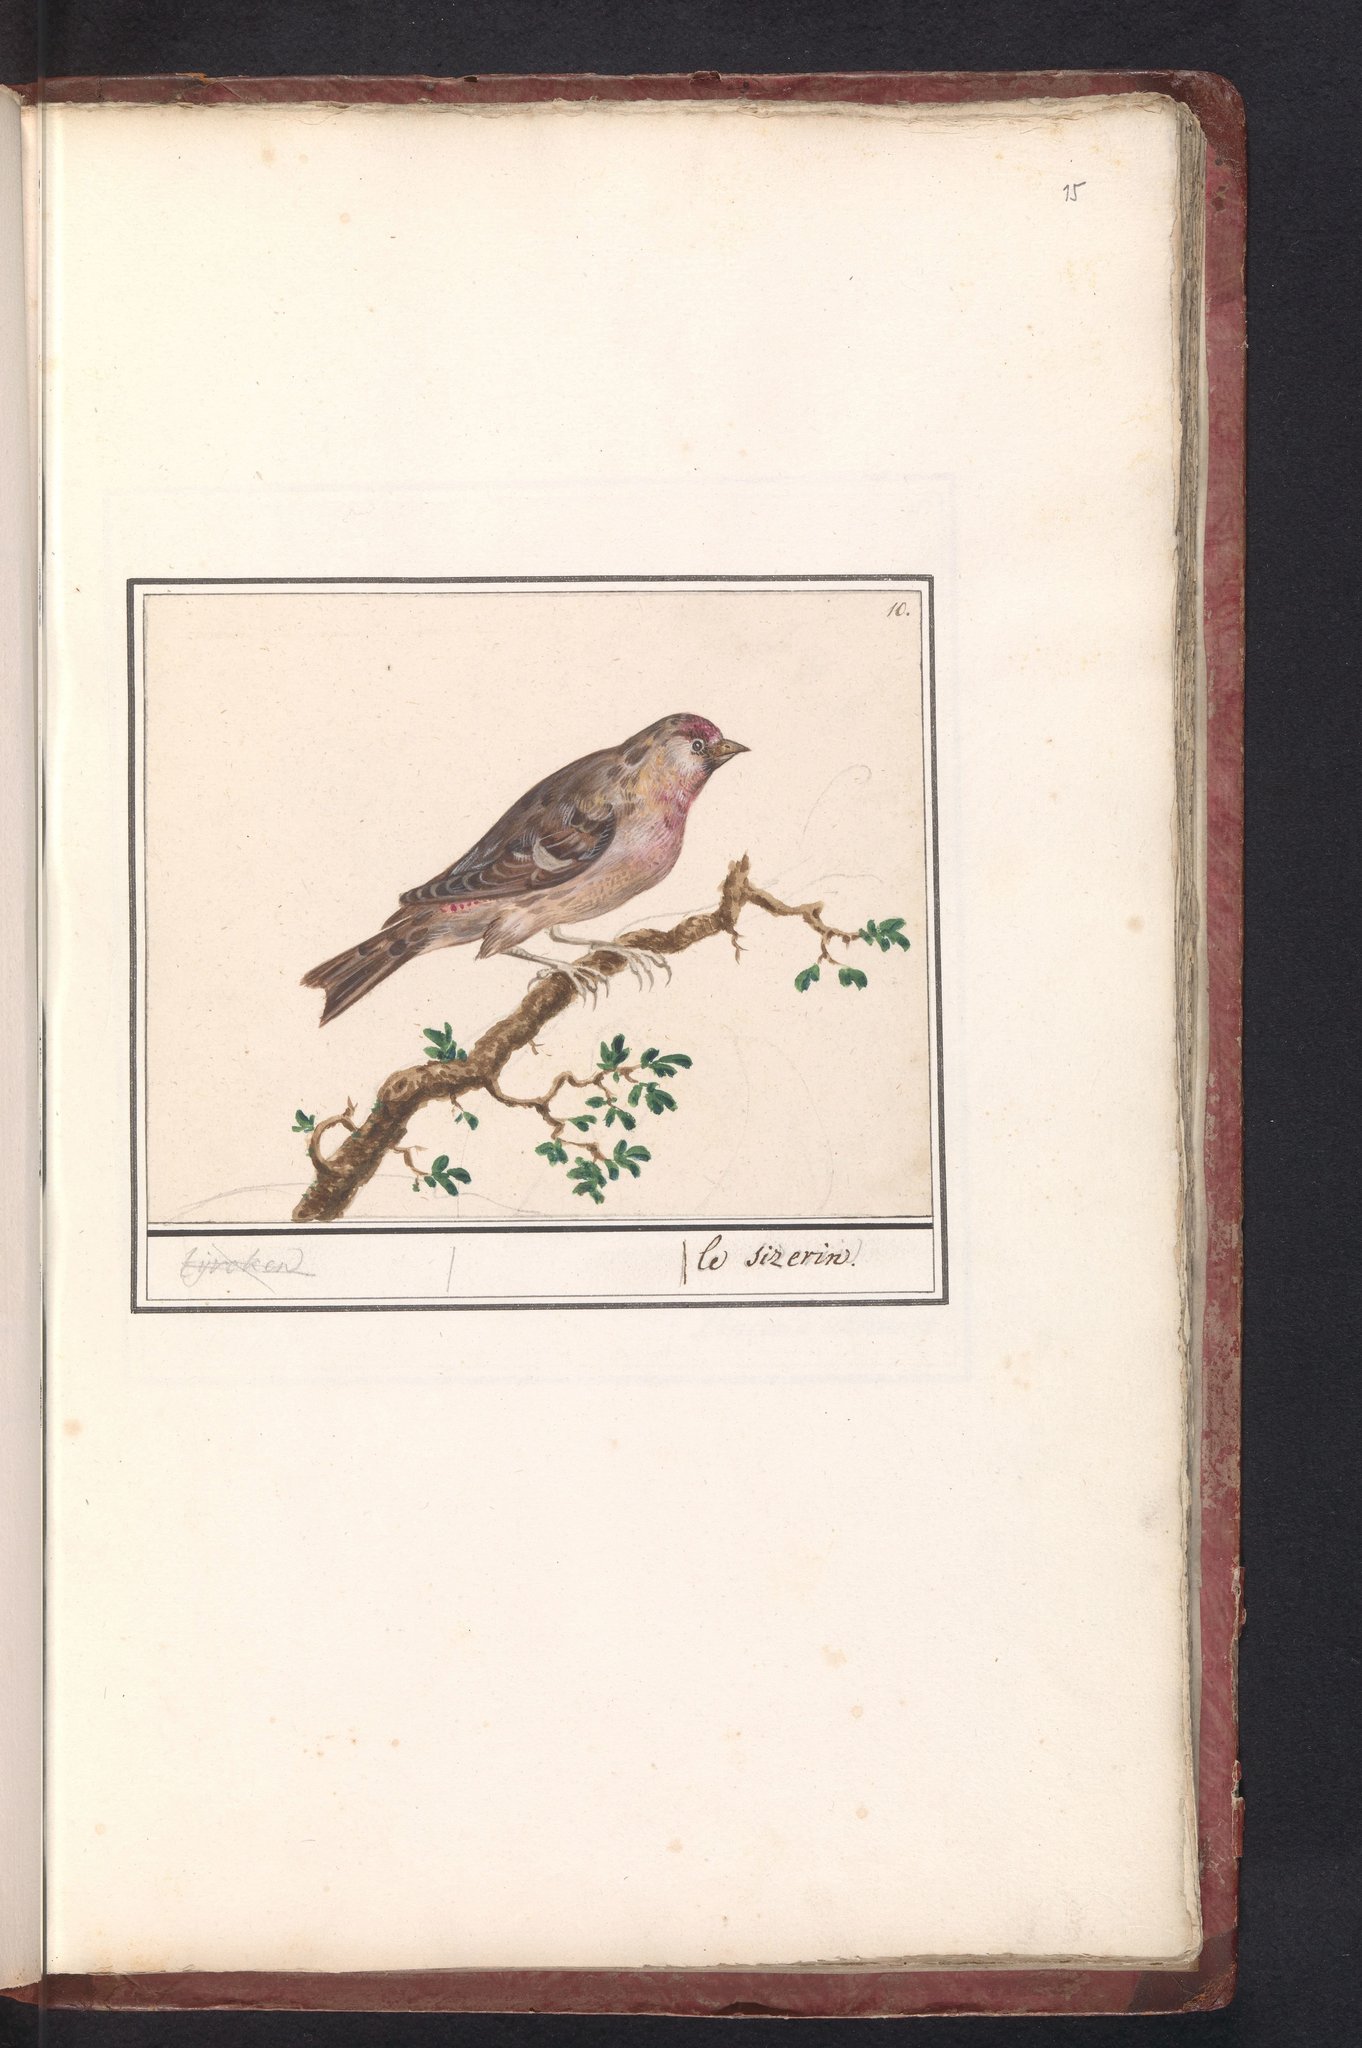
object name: drawing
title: le sizerin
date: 1596-1610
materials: paint, paper, pencil, watercolor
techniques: brush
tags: song-birds: common redpoll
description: Barmsijs. Genummerd rechtsboven: 10. Onderdeel van het tweede album met tekeningen van vogels. Vierde van twaalf albums met tekeningen van dieren, vogels en planten bekend rond 1600, gemaakt in opdracht van keizer Rudolf II. Met toelichting in Nederlands, Latijn en Frans.